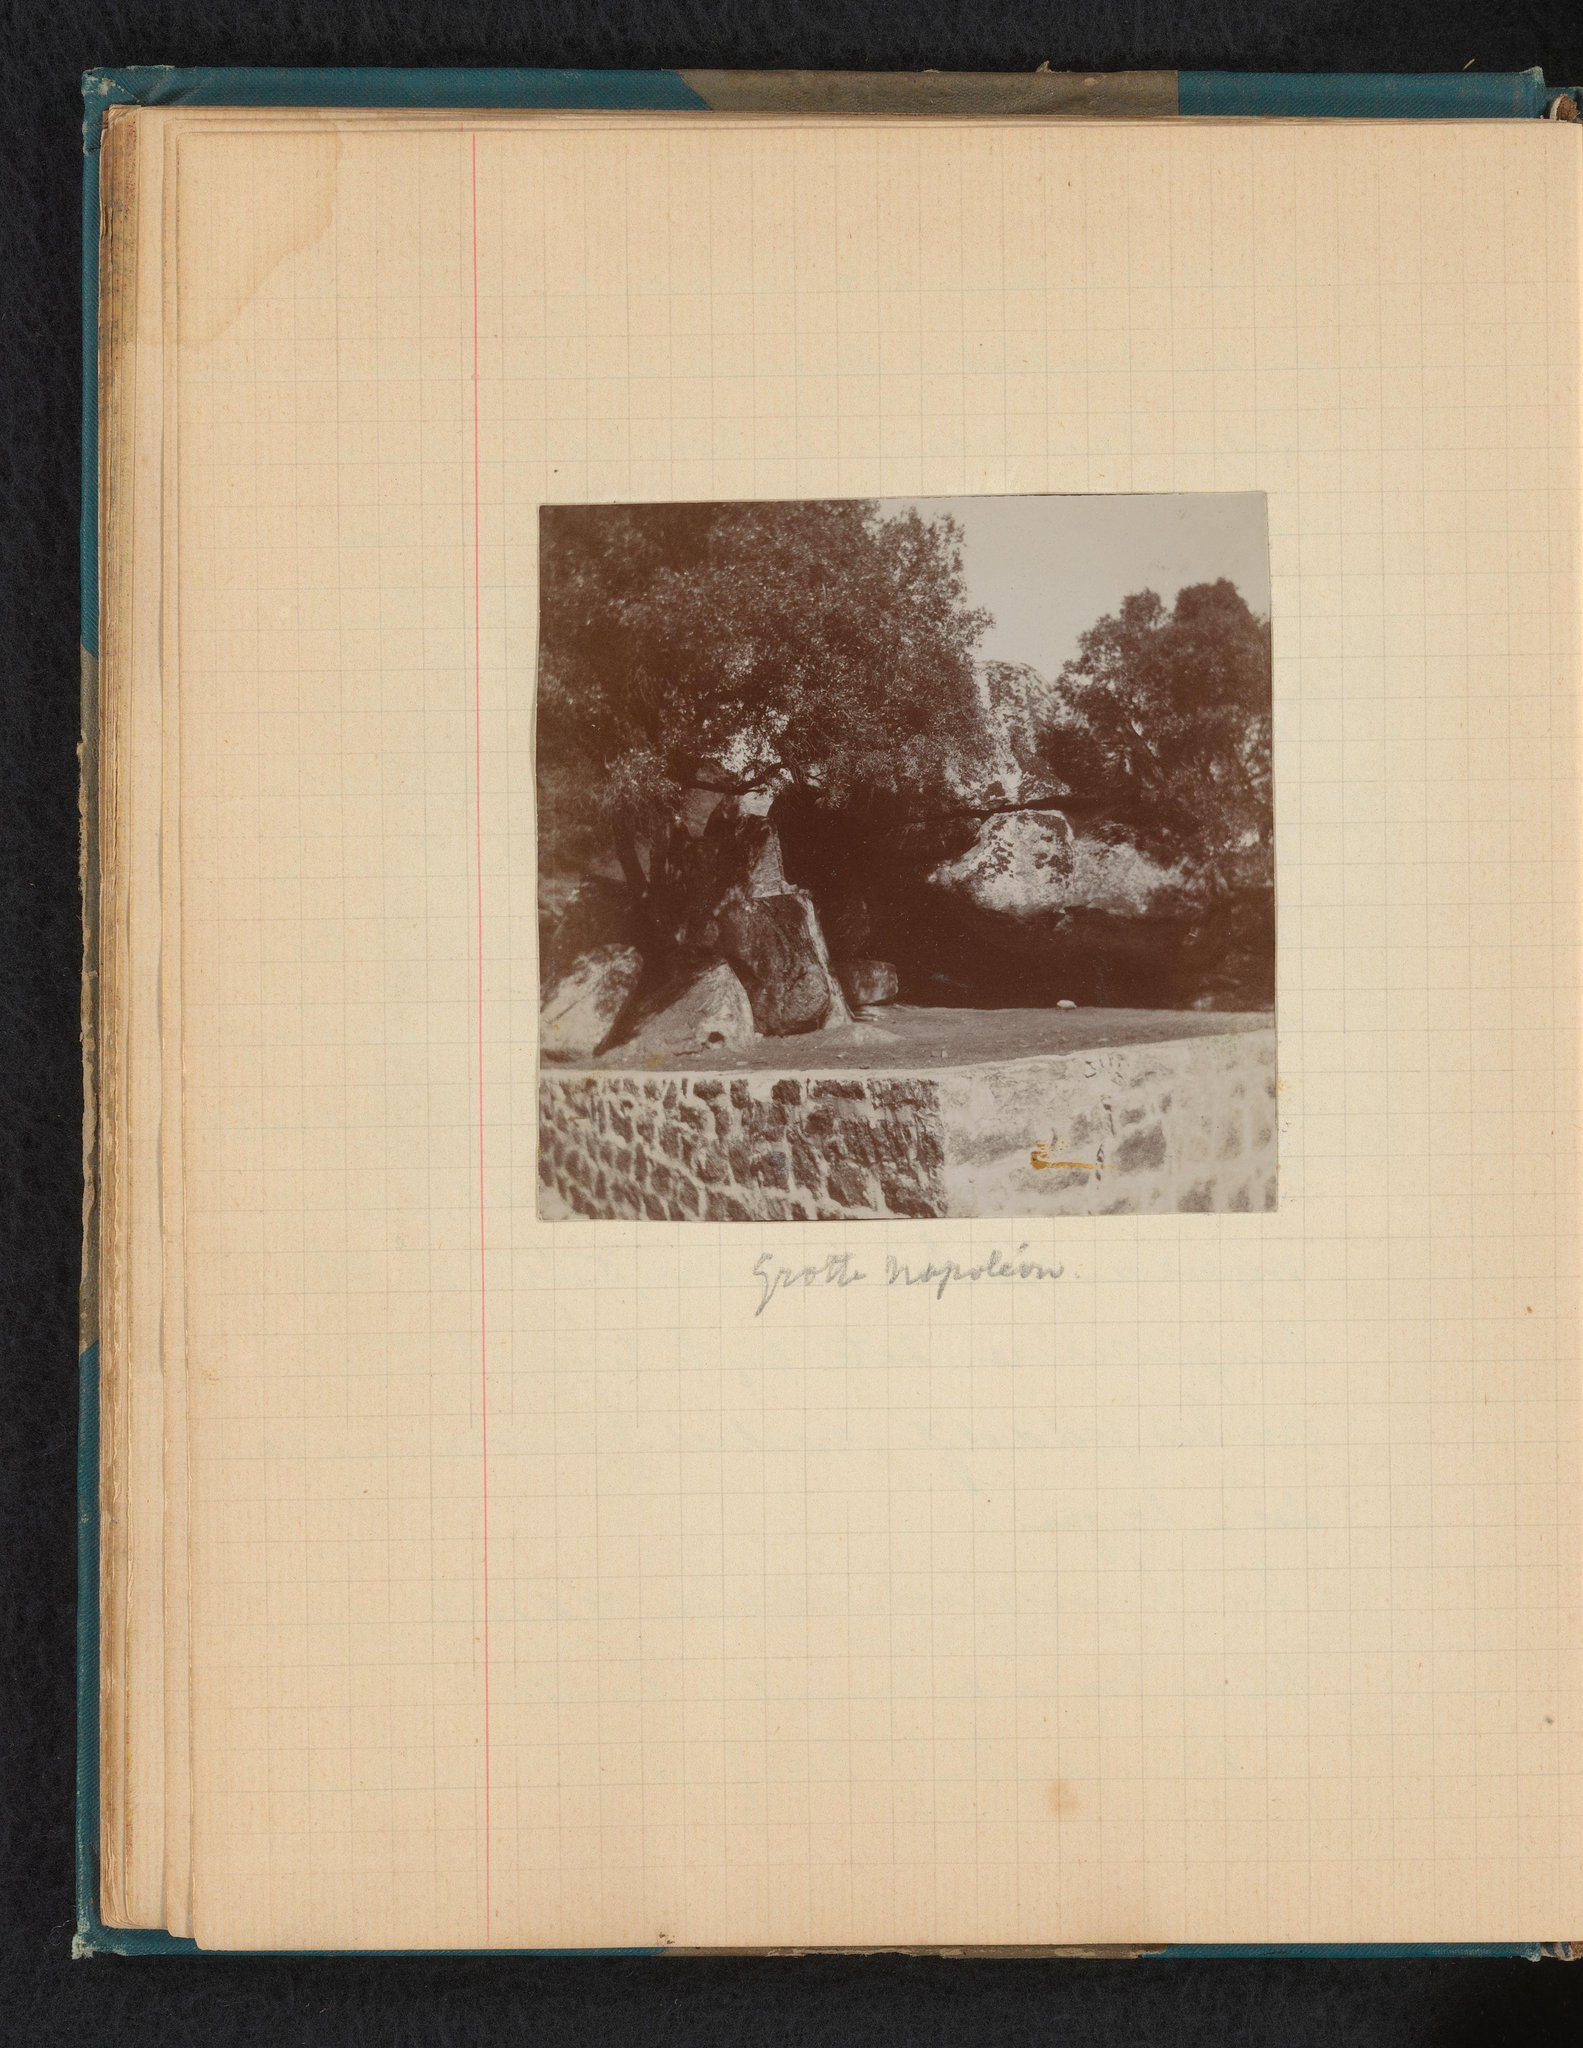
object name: album leaf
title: Grot Napoléon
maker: théodore van lelyveld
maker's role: painter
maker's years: 1867-1954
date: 1902-1904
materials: paper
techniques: gelatin silver print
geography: ajaccio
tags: cave, grotto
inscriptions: inscription: ‘Grotte Napoléon’